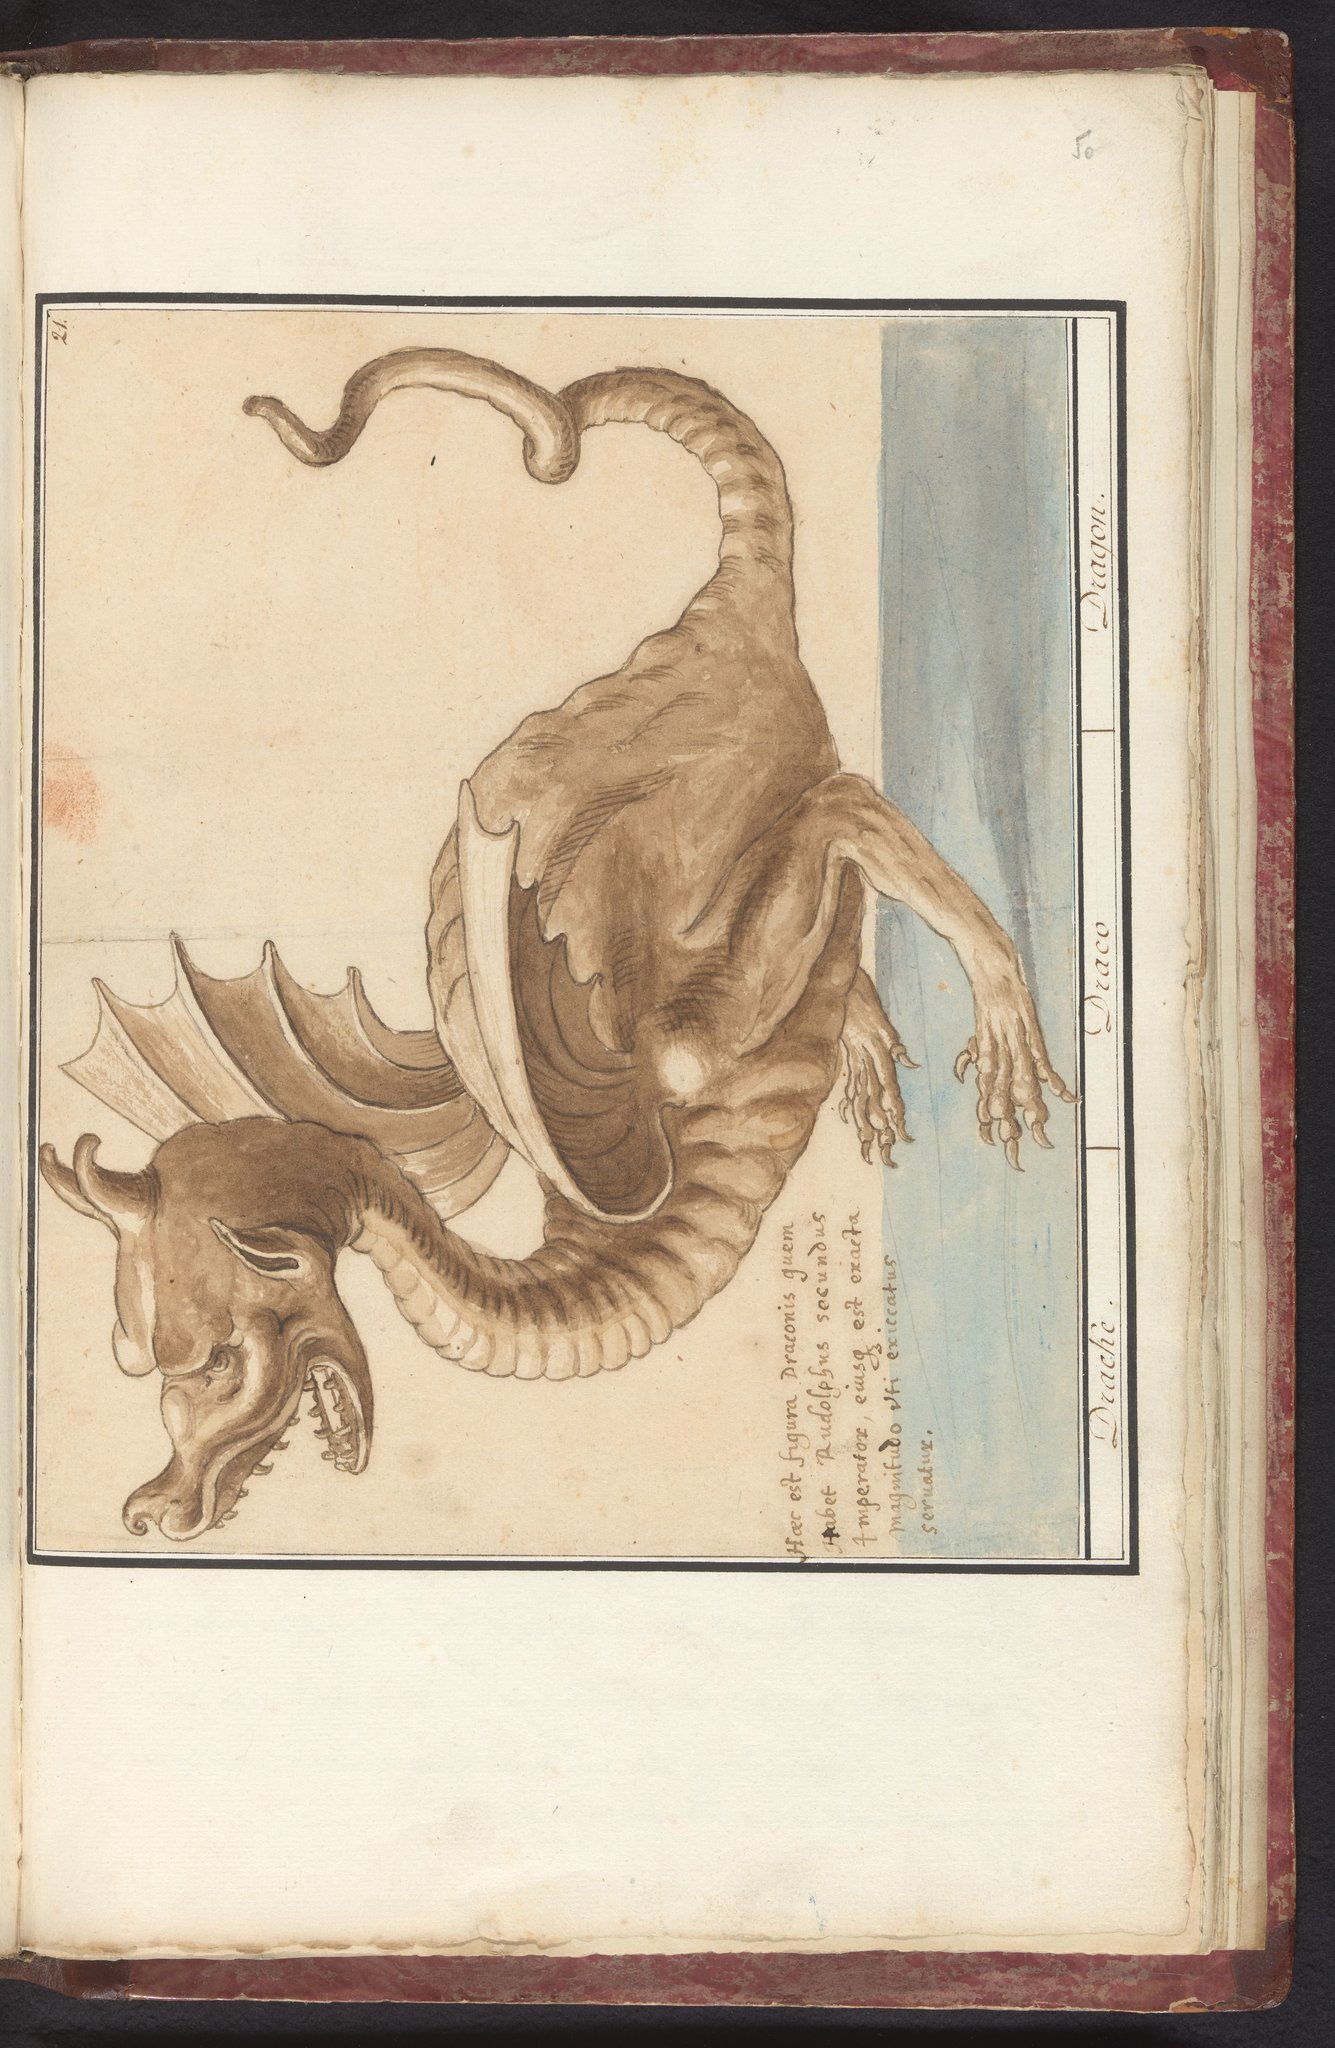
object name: drawing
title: Draak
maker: anselmus boëtius de boodt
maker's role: draughtsman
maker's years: 1550-1632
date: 1596-1610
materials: chalk, ink, paper, pencil, watercolor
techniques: brush, pen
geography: prague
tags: dragon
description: Draak. Links een opschrift in het Latijn. Genummerd rechtsboven: 21. Onderdeel van het zevende album met tekeningen van reptielen, amfibieën en natuurhistorische ensembles. Het zevende van twaalf albums met aquarellen van dieren, vogels en planten bekend rond 1600, gemaakt in opdracht van keizer Rudolf II. Met toelichting in Nederlands, Latijn en Frans.